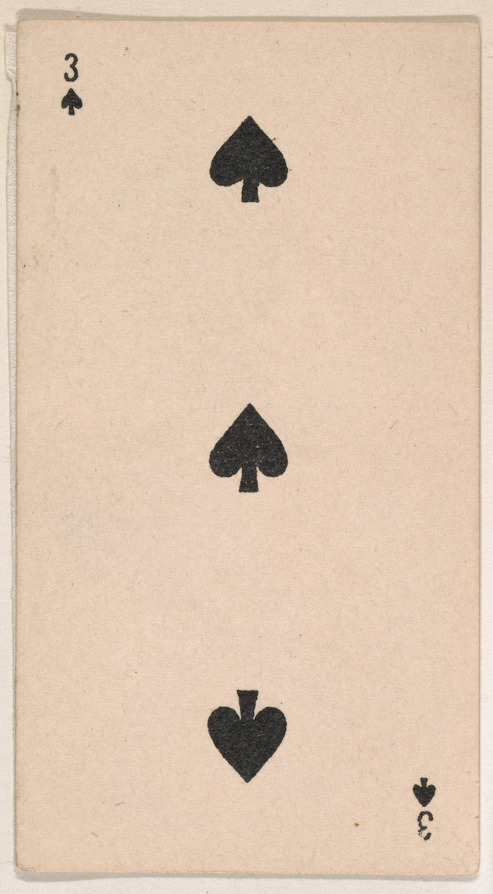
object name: print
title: Three of Spades, from the Transparent Playing Cards series (N220) issued by Kinney Bros.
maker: kinney brothers tobacco company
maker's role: publisher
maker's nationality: american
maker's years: 1869-2011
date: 1888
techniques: color lithograph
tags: playing cards